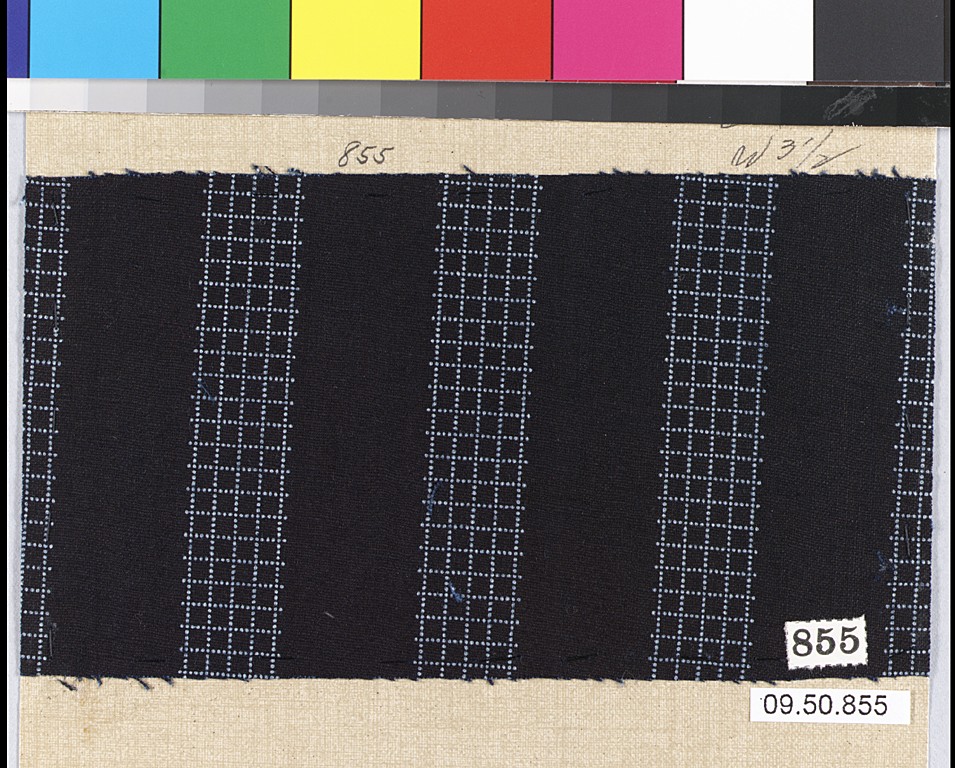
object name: piece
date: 1801-1900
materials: cotton